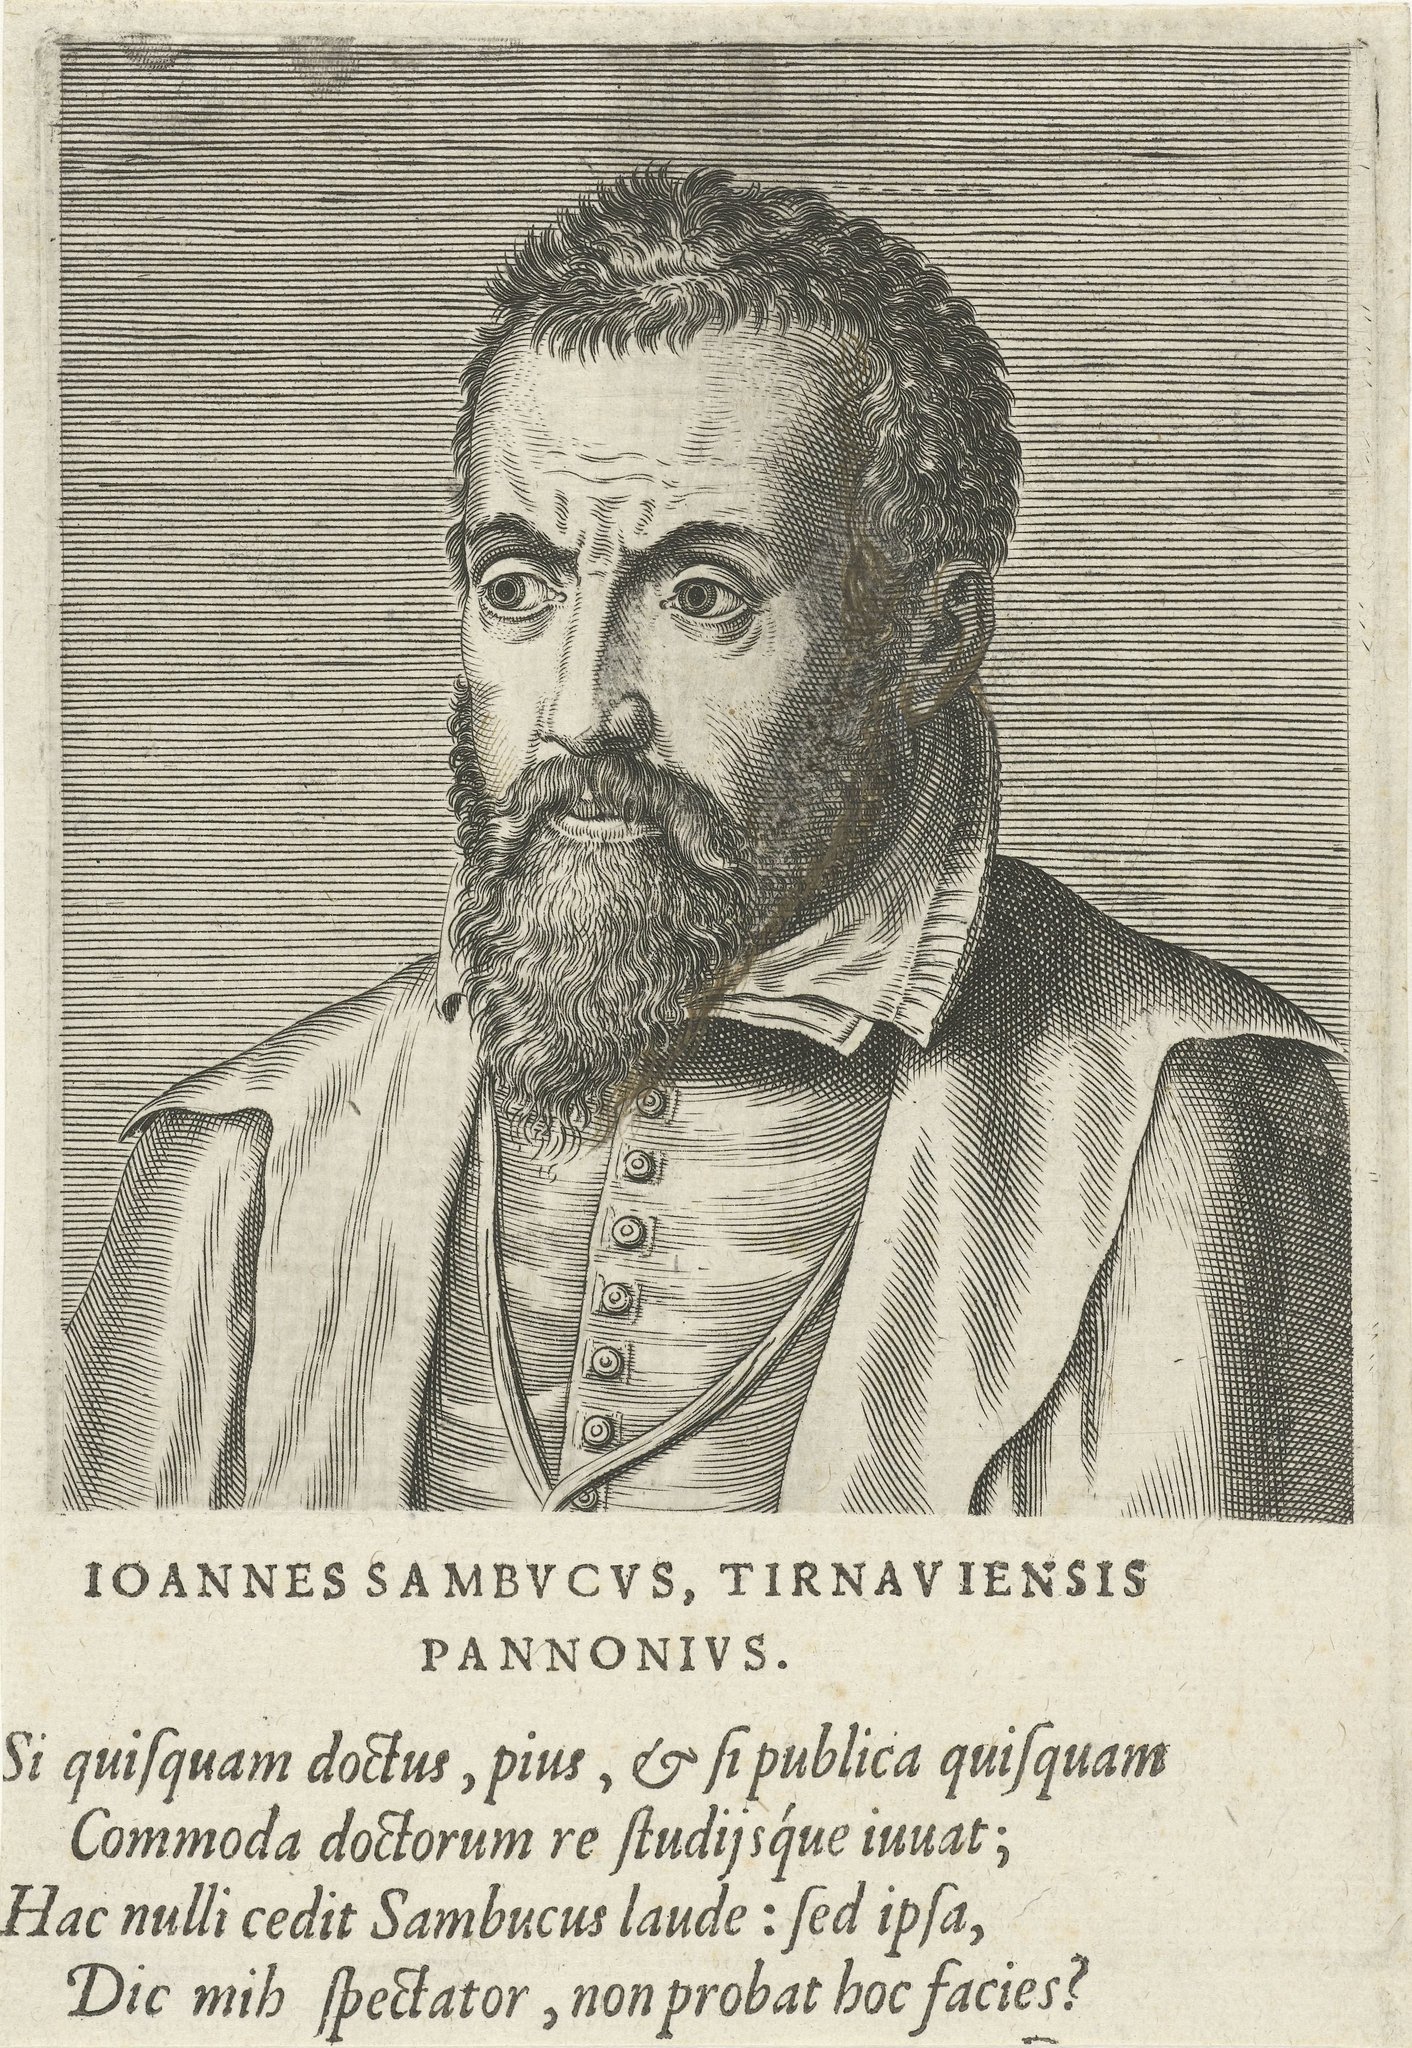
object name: print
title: Dubbelportret van Samuel Hahnemann en Francois Broussais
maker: johann christian ernst müller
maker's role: draughtsman, print maker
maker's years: 1766-1824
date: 1776-1824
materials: paper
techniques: engraving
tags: paris, historical persons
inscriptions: collector's mark: Lugt 2228